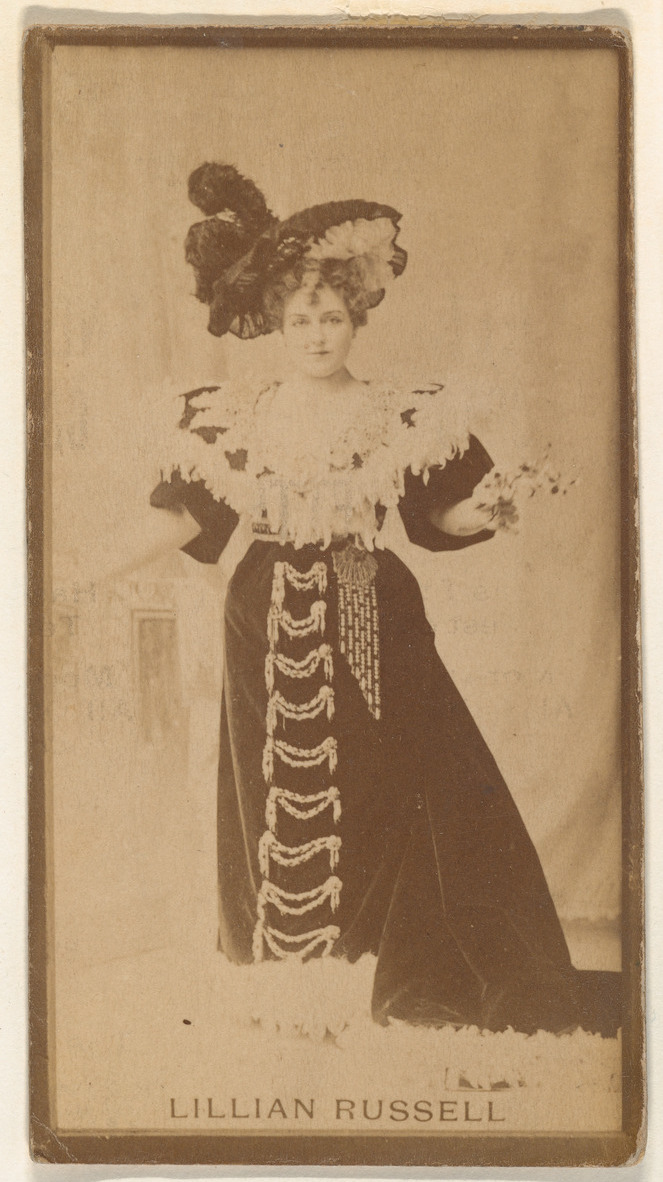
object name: photograph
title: Lillian Russell, from the Actresses series (N668)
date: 1888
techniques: albumen silver print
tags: portraits,women,actresses